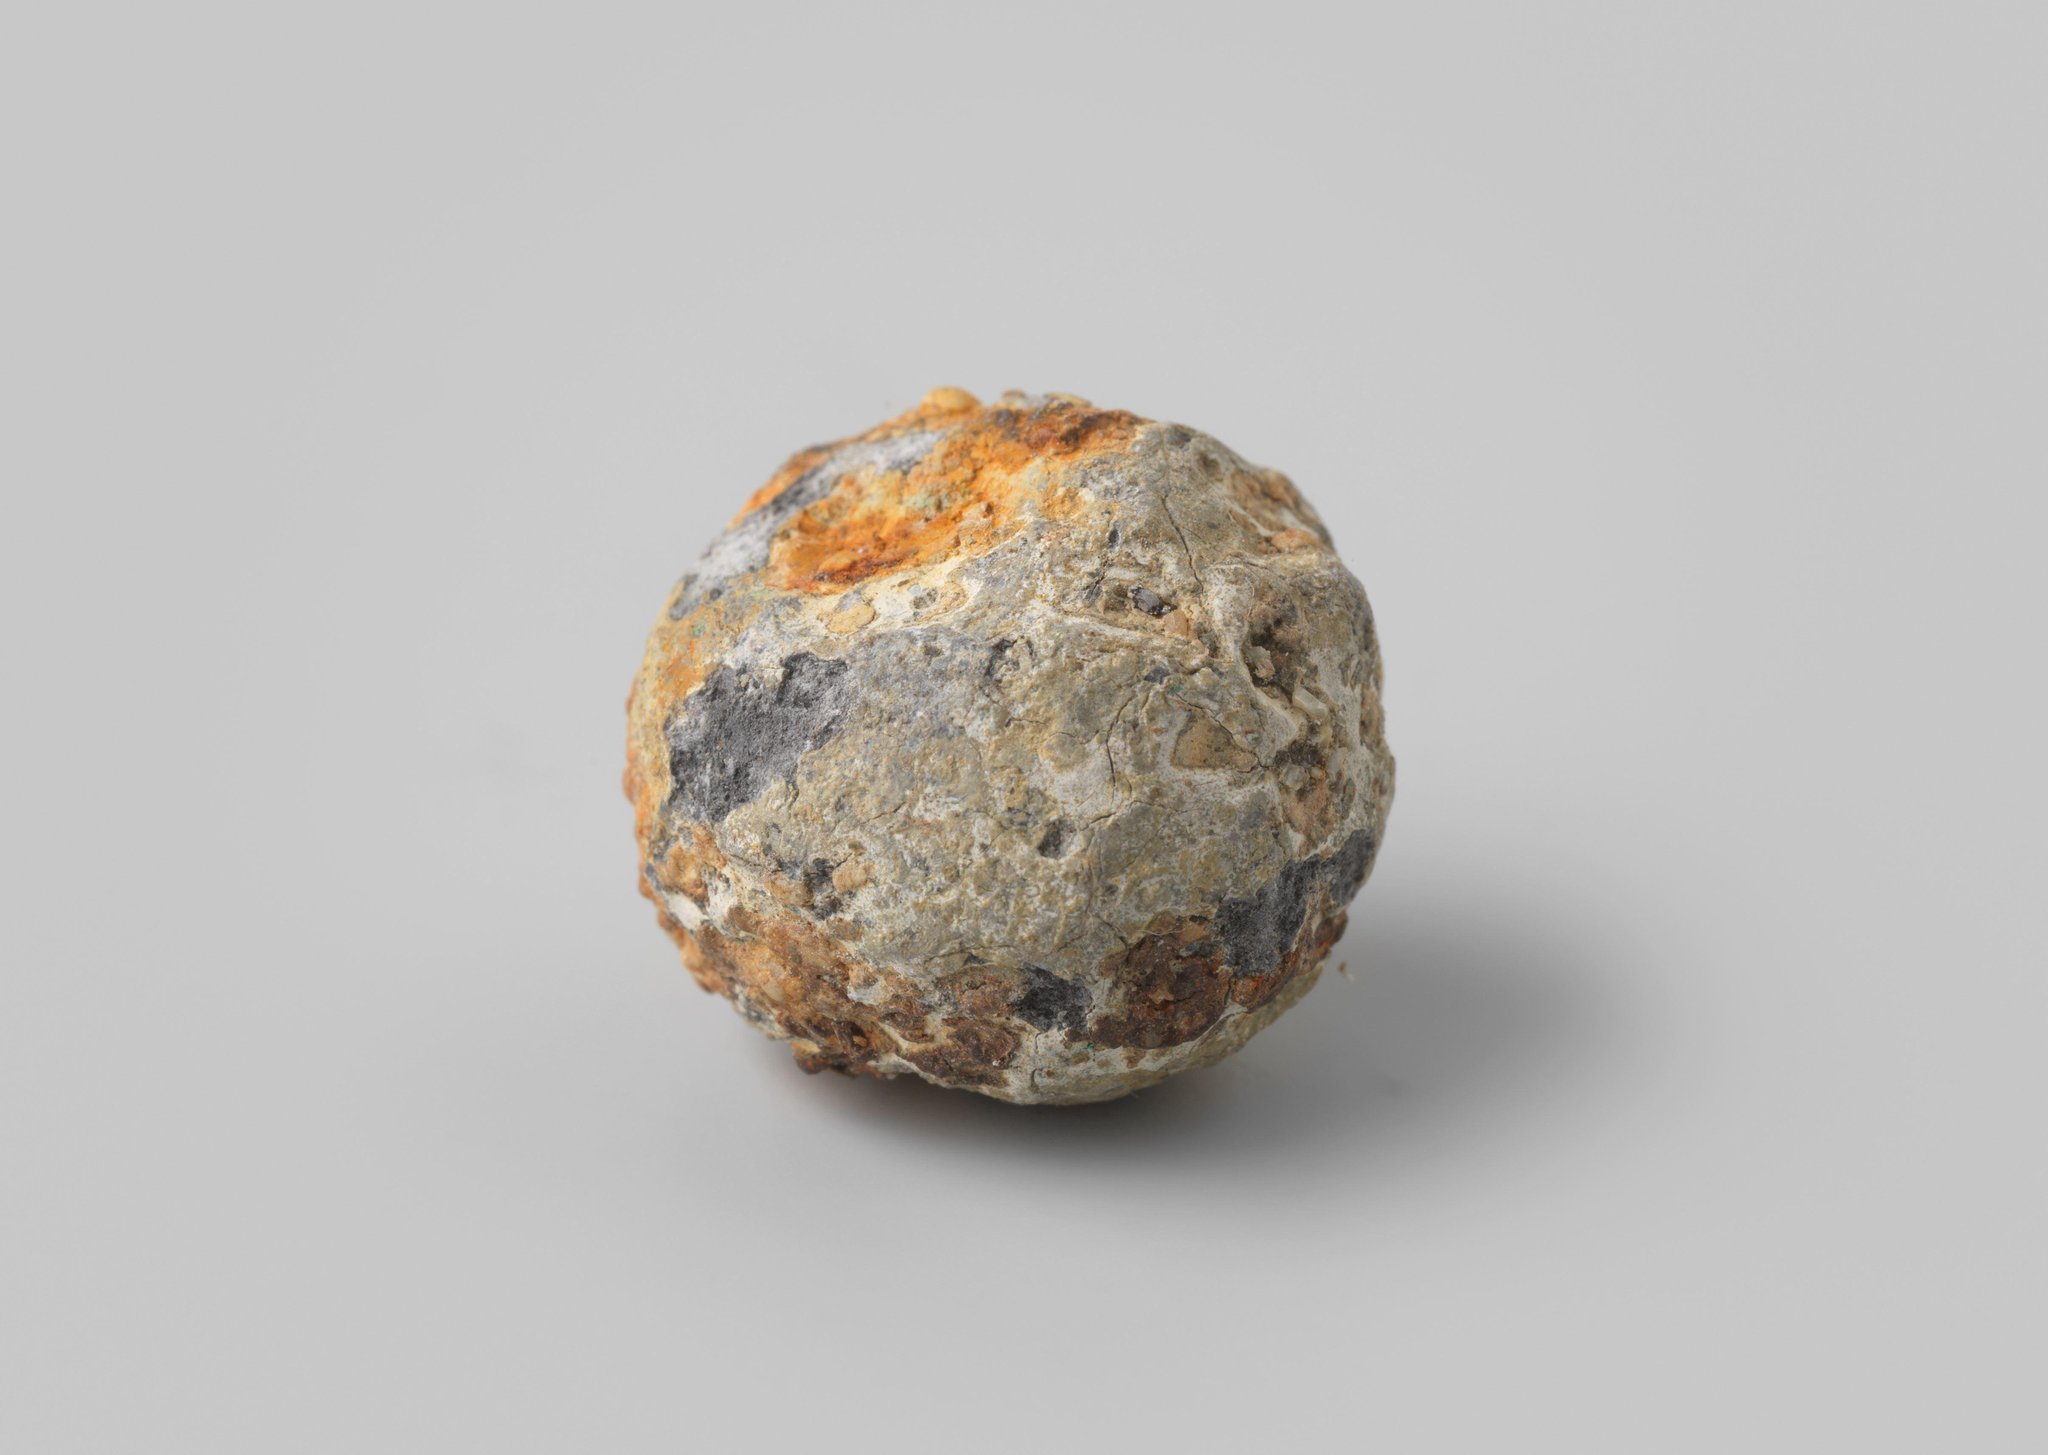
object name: musketkogel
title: Musketkogel uit het wrak van de Oost-Indiëvaarder Hollandia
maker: Anonymous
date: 1700-1743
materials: lead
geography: netherlands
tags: verenigde oostindische compagnie, hollandia (schip), annet